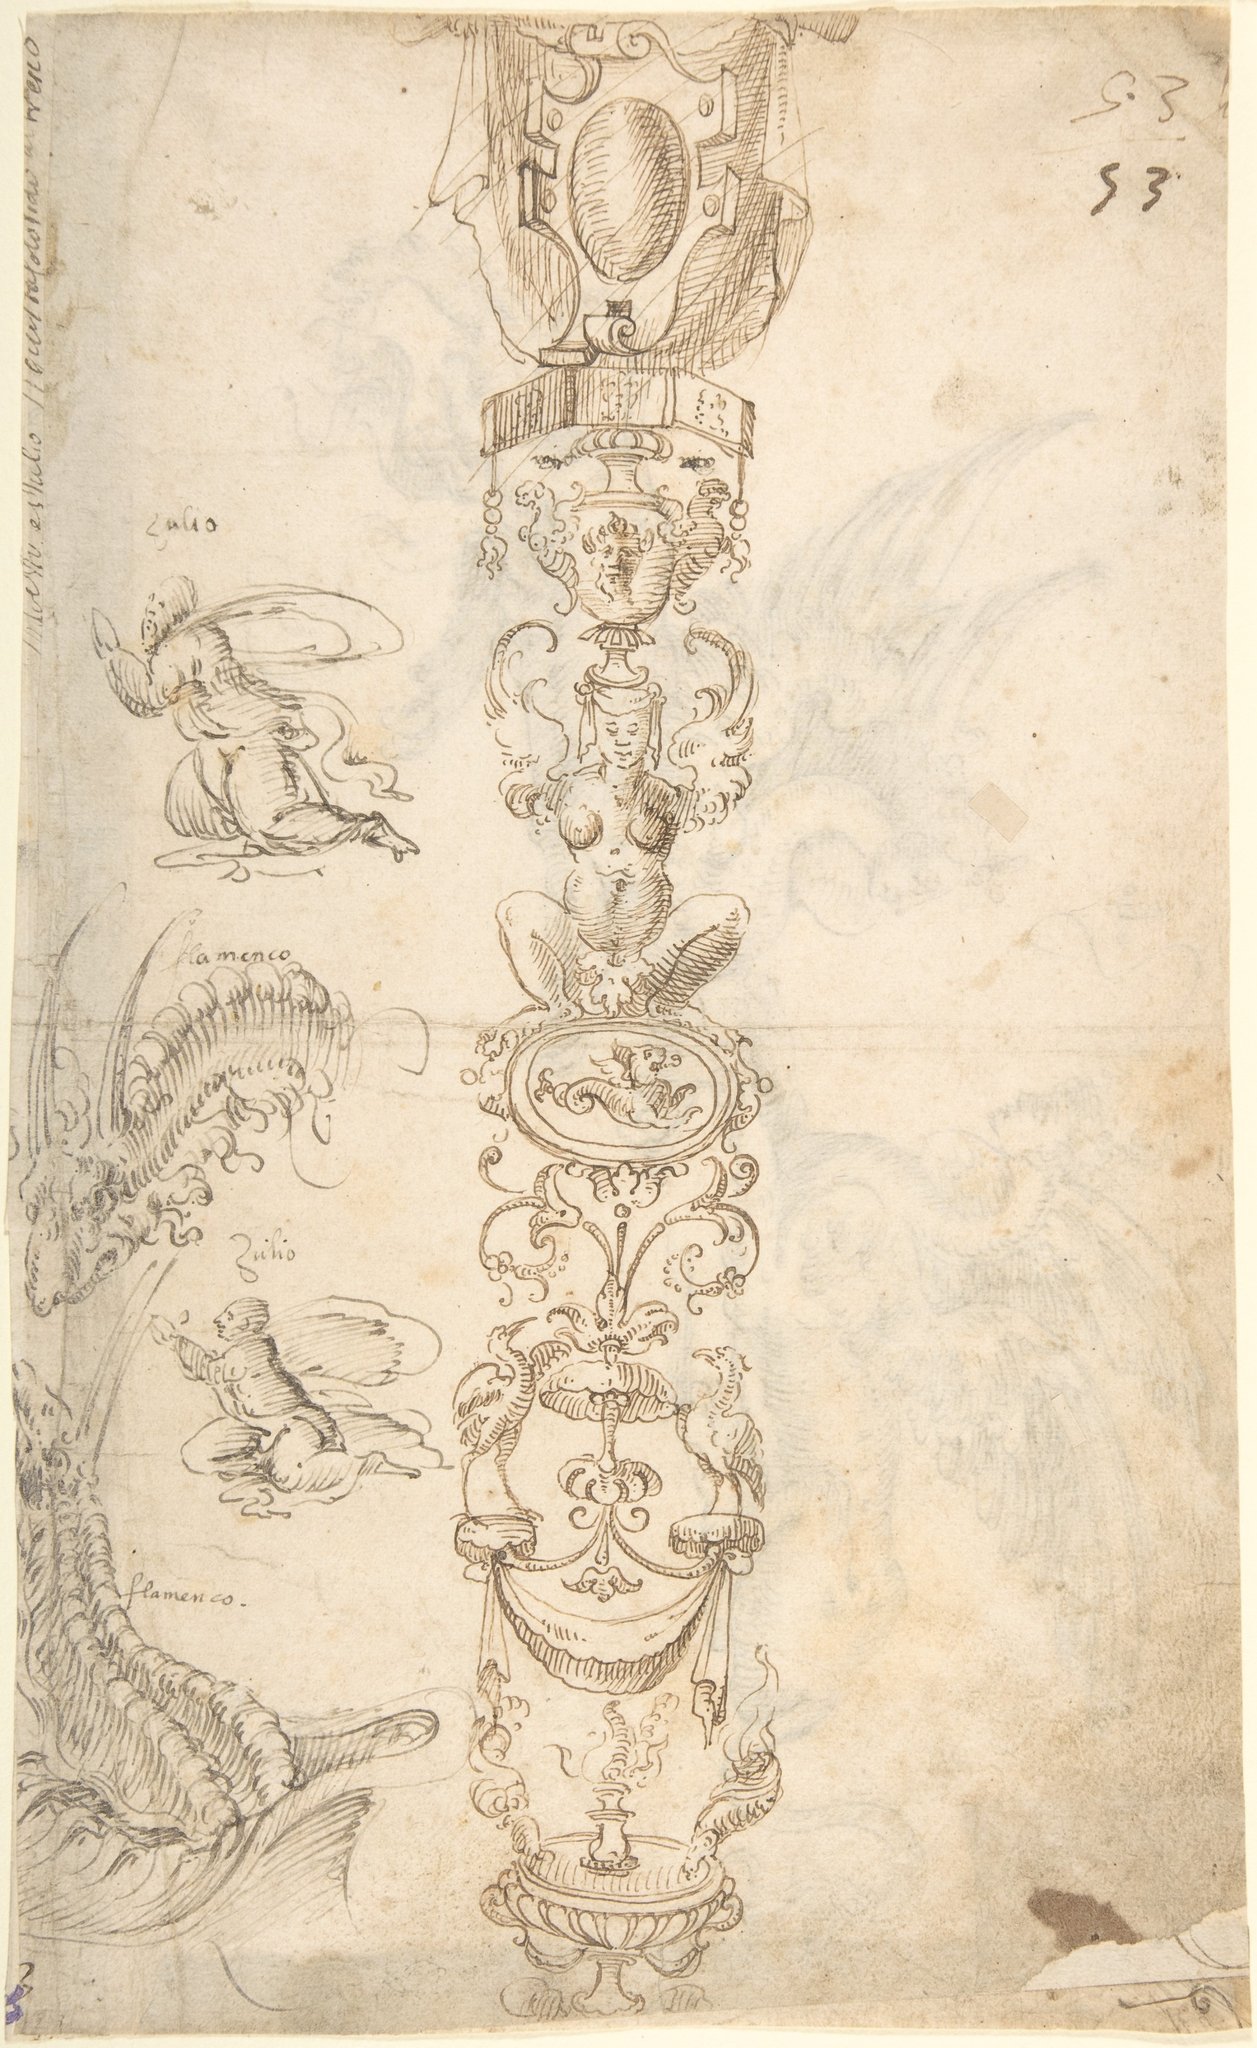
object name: drawing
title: Candelabra grotesque and studies of kneeling figures (recto); two sphinxes (verso)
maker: andrés de melgar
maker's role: artist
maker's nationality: spanish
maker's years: 1554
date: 1545-1560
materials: ink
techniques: pen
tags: birds,grotesques,ornament,mythical creatures,griffins